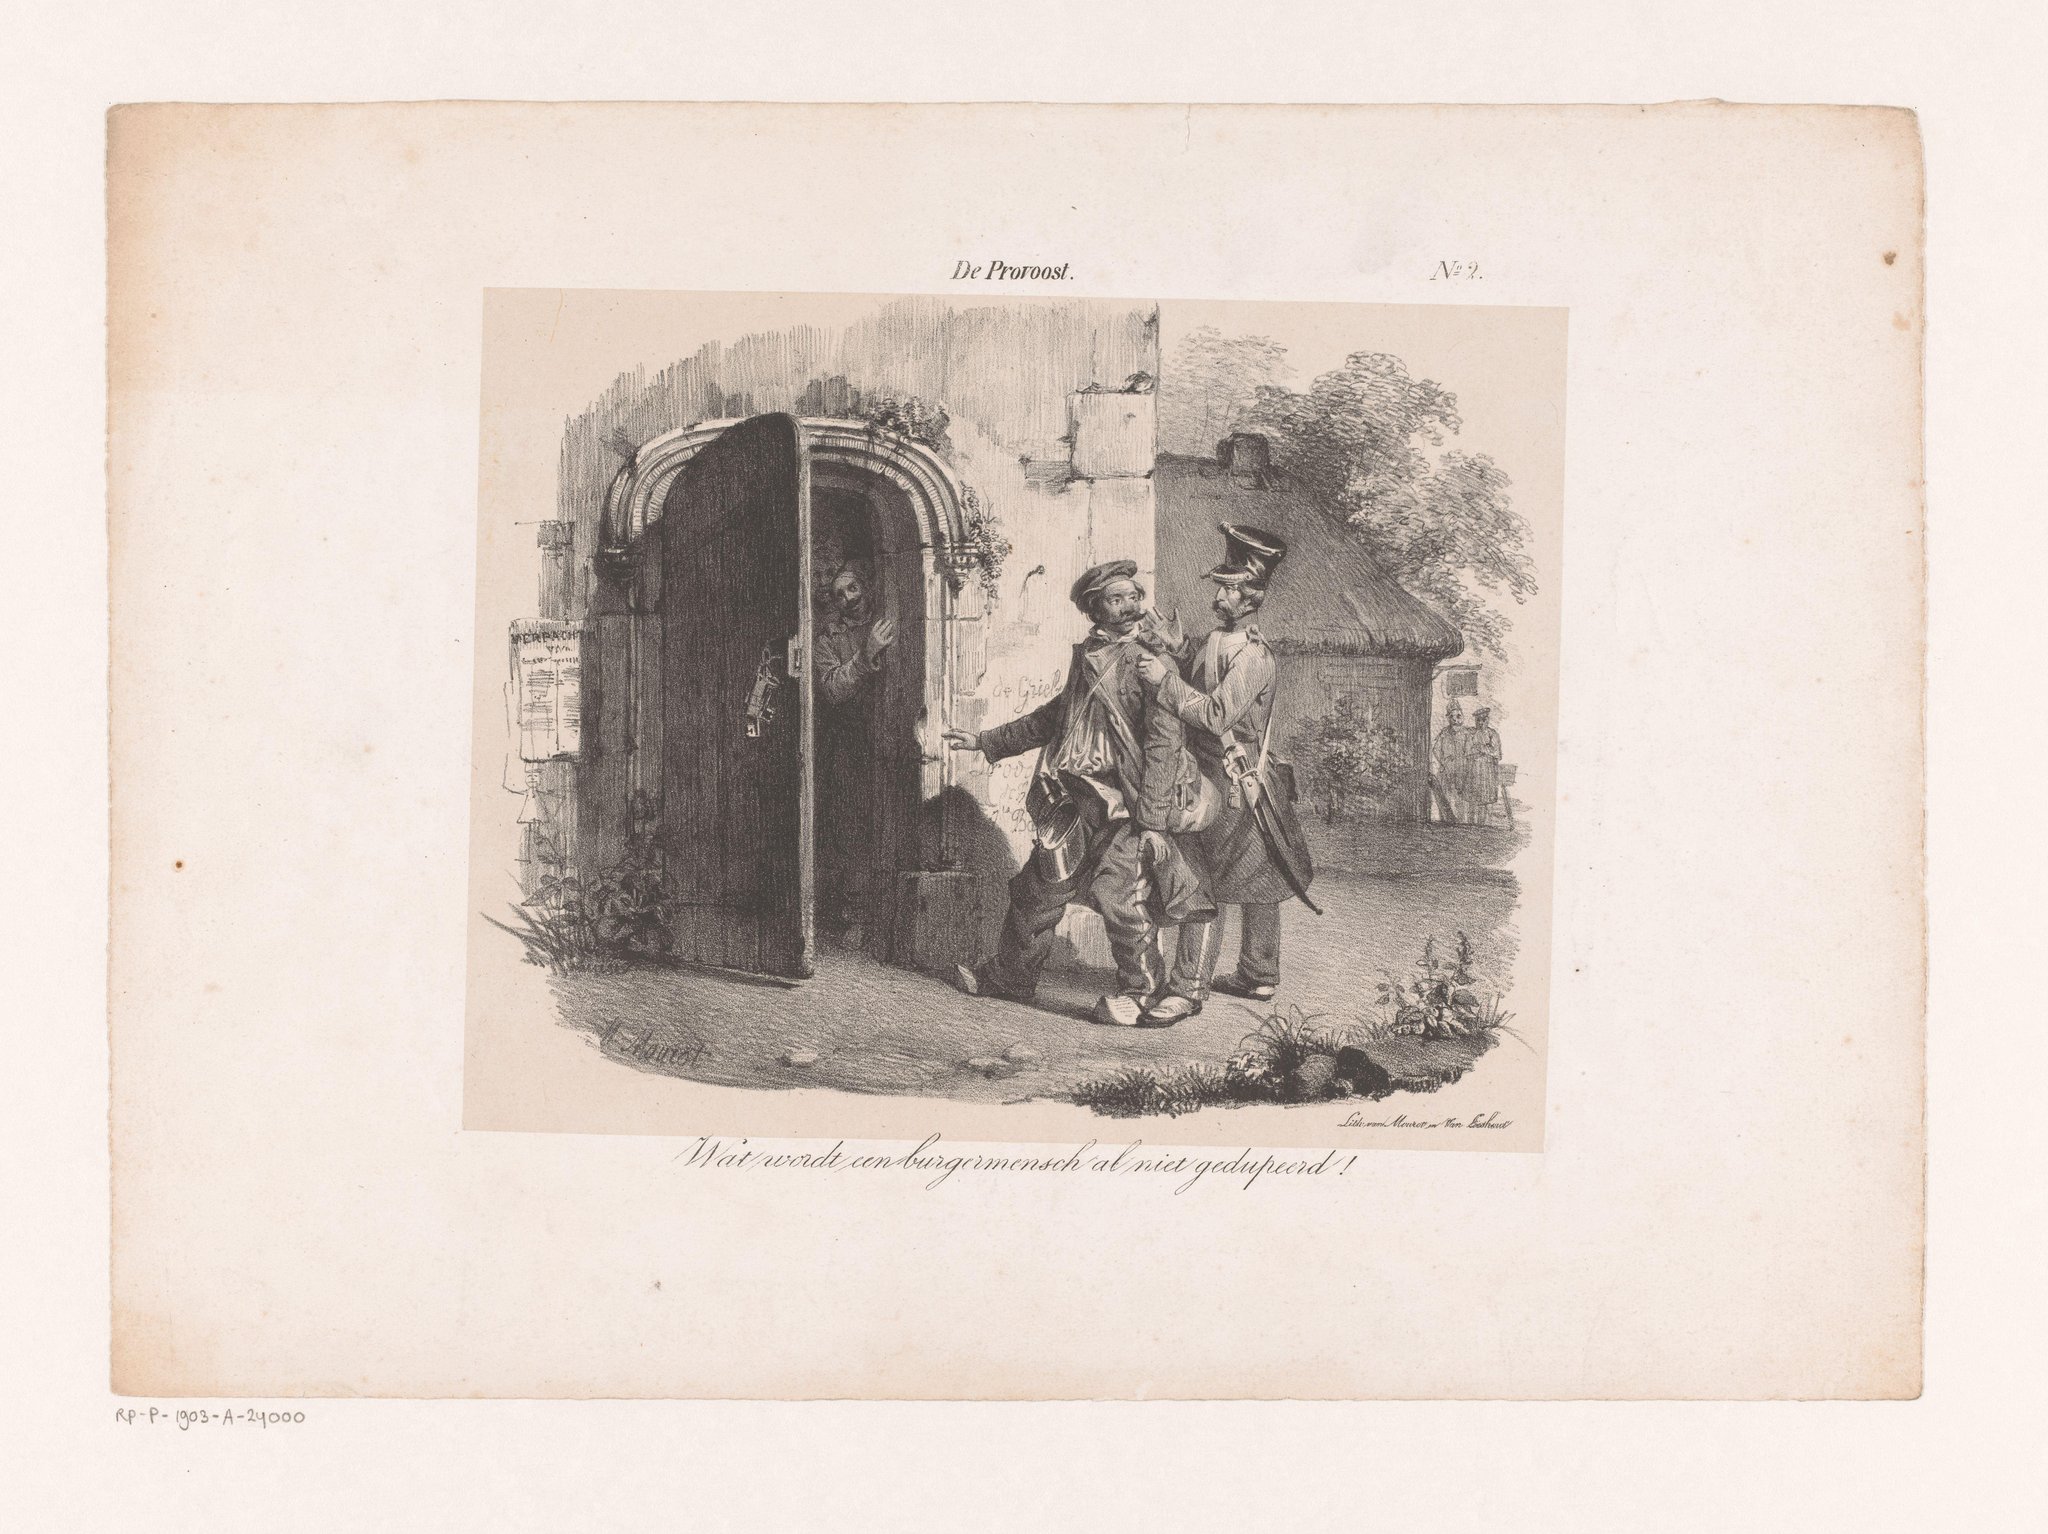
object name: print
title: Provoost arresteert militair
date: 1835-1838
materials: paper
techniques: lithograph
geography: den bosch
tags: arrest ~ military service, military police, provost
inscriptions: collector's mark: Lugt 2228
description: Een hooggeplaatste officier arresteert een slordig uitziende militair op klompen. Hij begeleidt hem naar een toren waar twee figuren in de deuropening staan. Onder de afbeelding de verzuchting van de militair: 'Wat wordt een burgermensch al niet gedupeerd!'. Genummerd rechtsboven: No. 2.